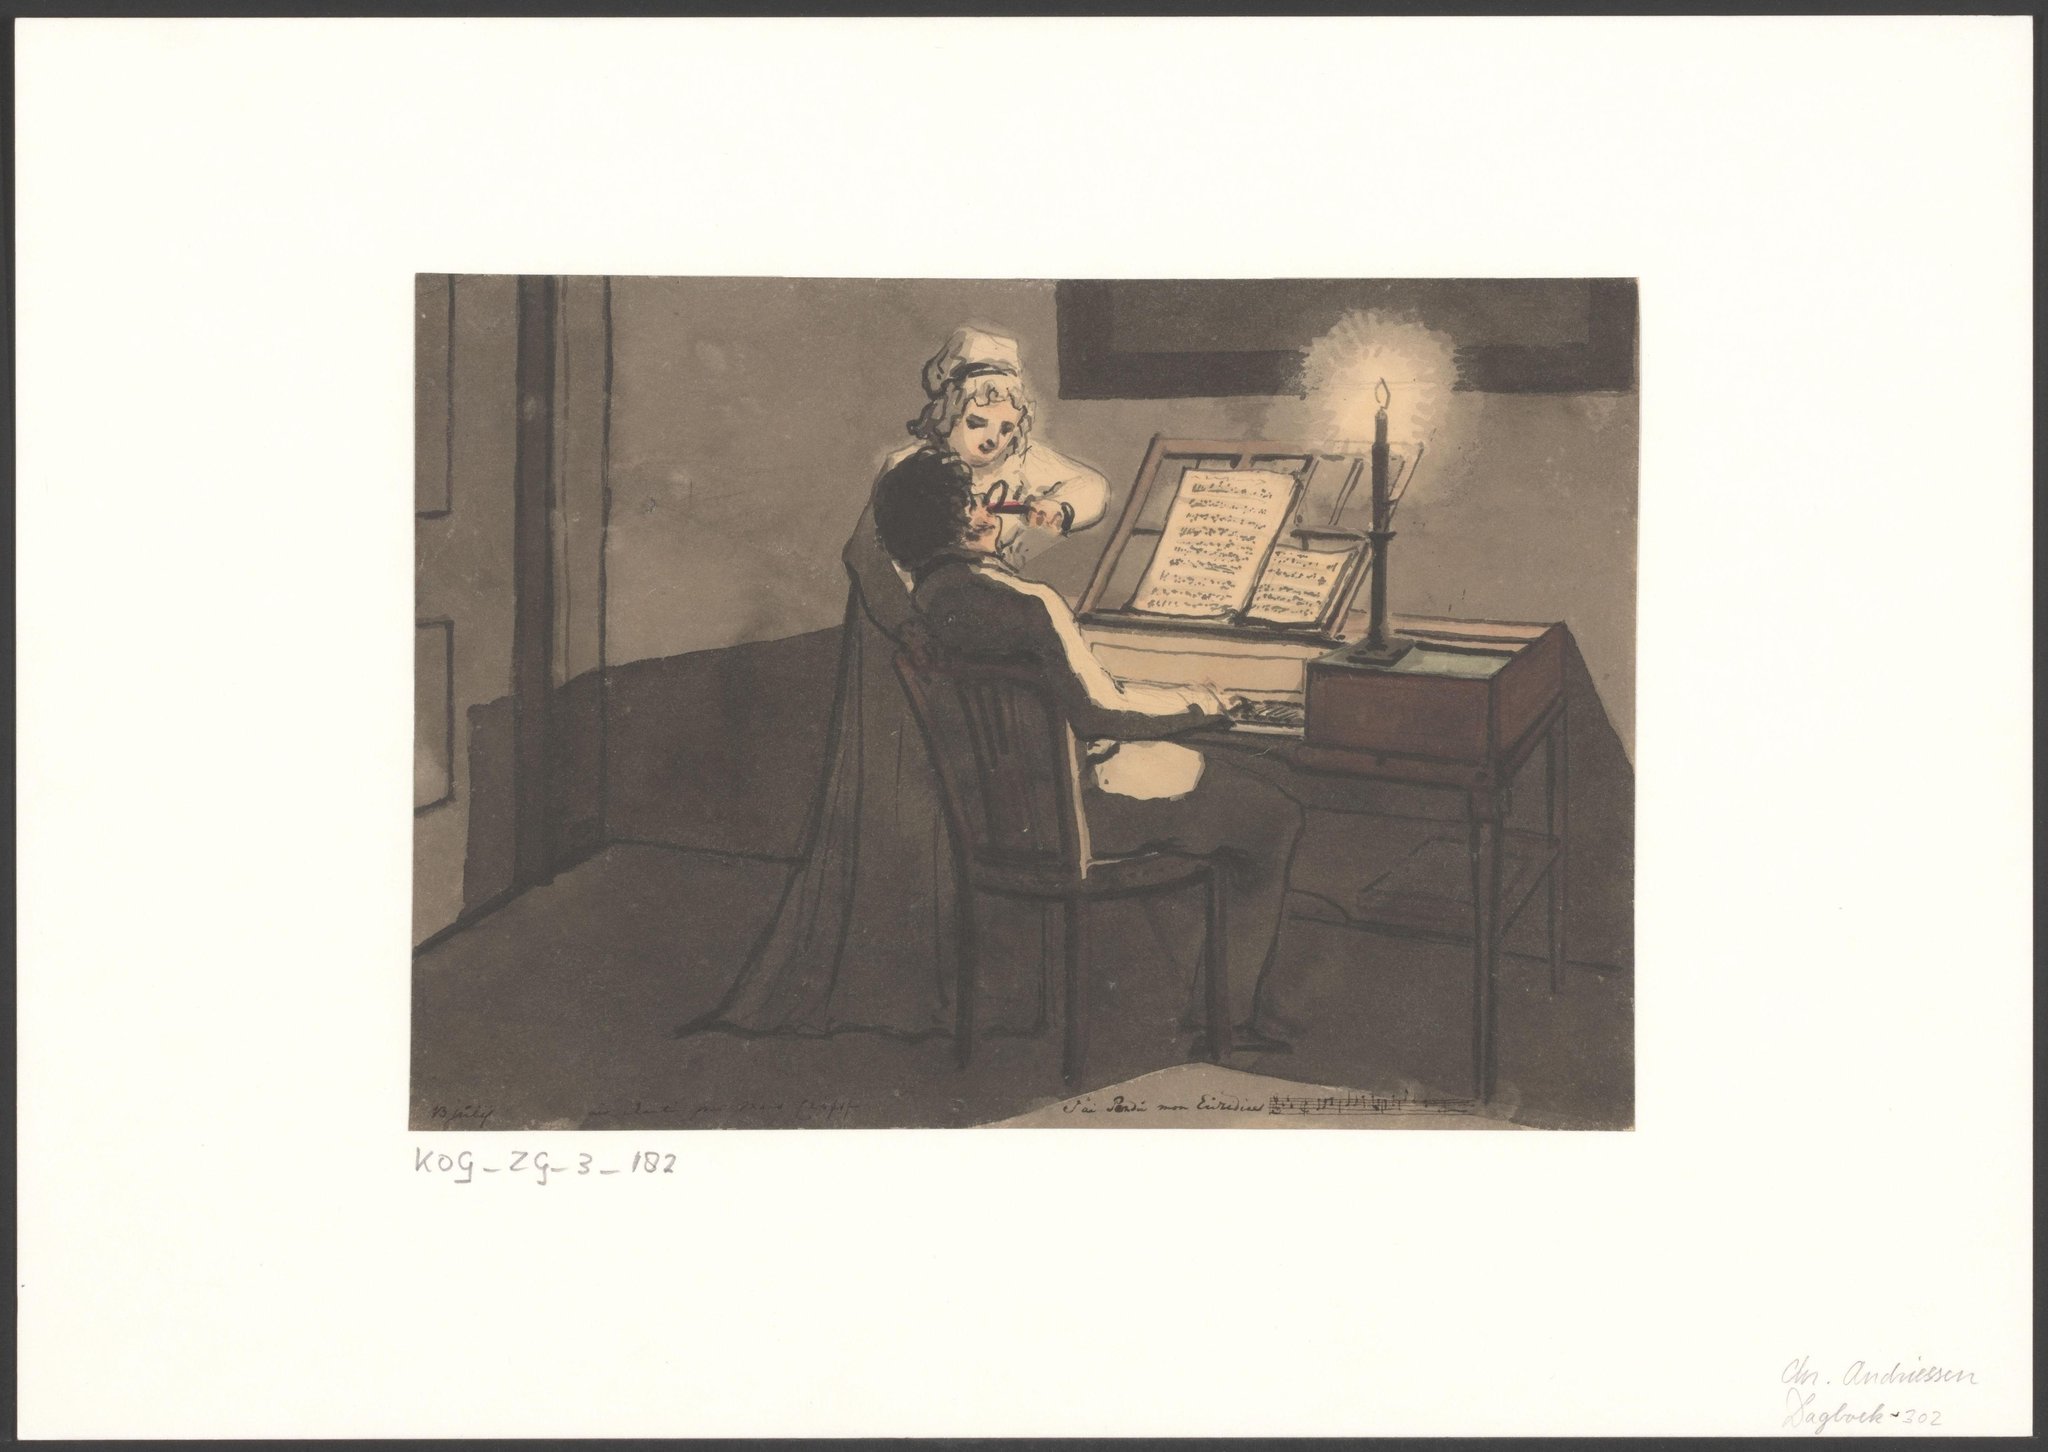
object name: drawing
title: P.A. Croese zit achter de tafelpiano terwijl een vrouw wijn in zijn mond giet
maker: christiaan andriessen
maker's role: draughtsman, print maker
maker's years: 1775-1846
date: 1806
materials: ink, paper, pencil, watercolor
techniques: brush, pen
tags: pouring, glass of wine, pianoforte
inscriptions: inscription: ‘13 julij J'ai perdu mon Euridice’, signature: ‘J Andriessen’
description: Dagboekblad uit het getekende dagboek dat Christiaan Andriessen bijhield van 1805 tot en met 1808.